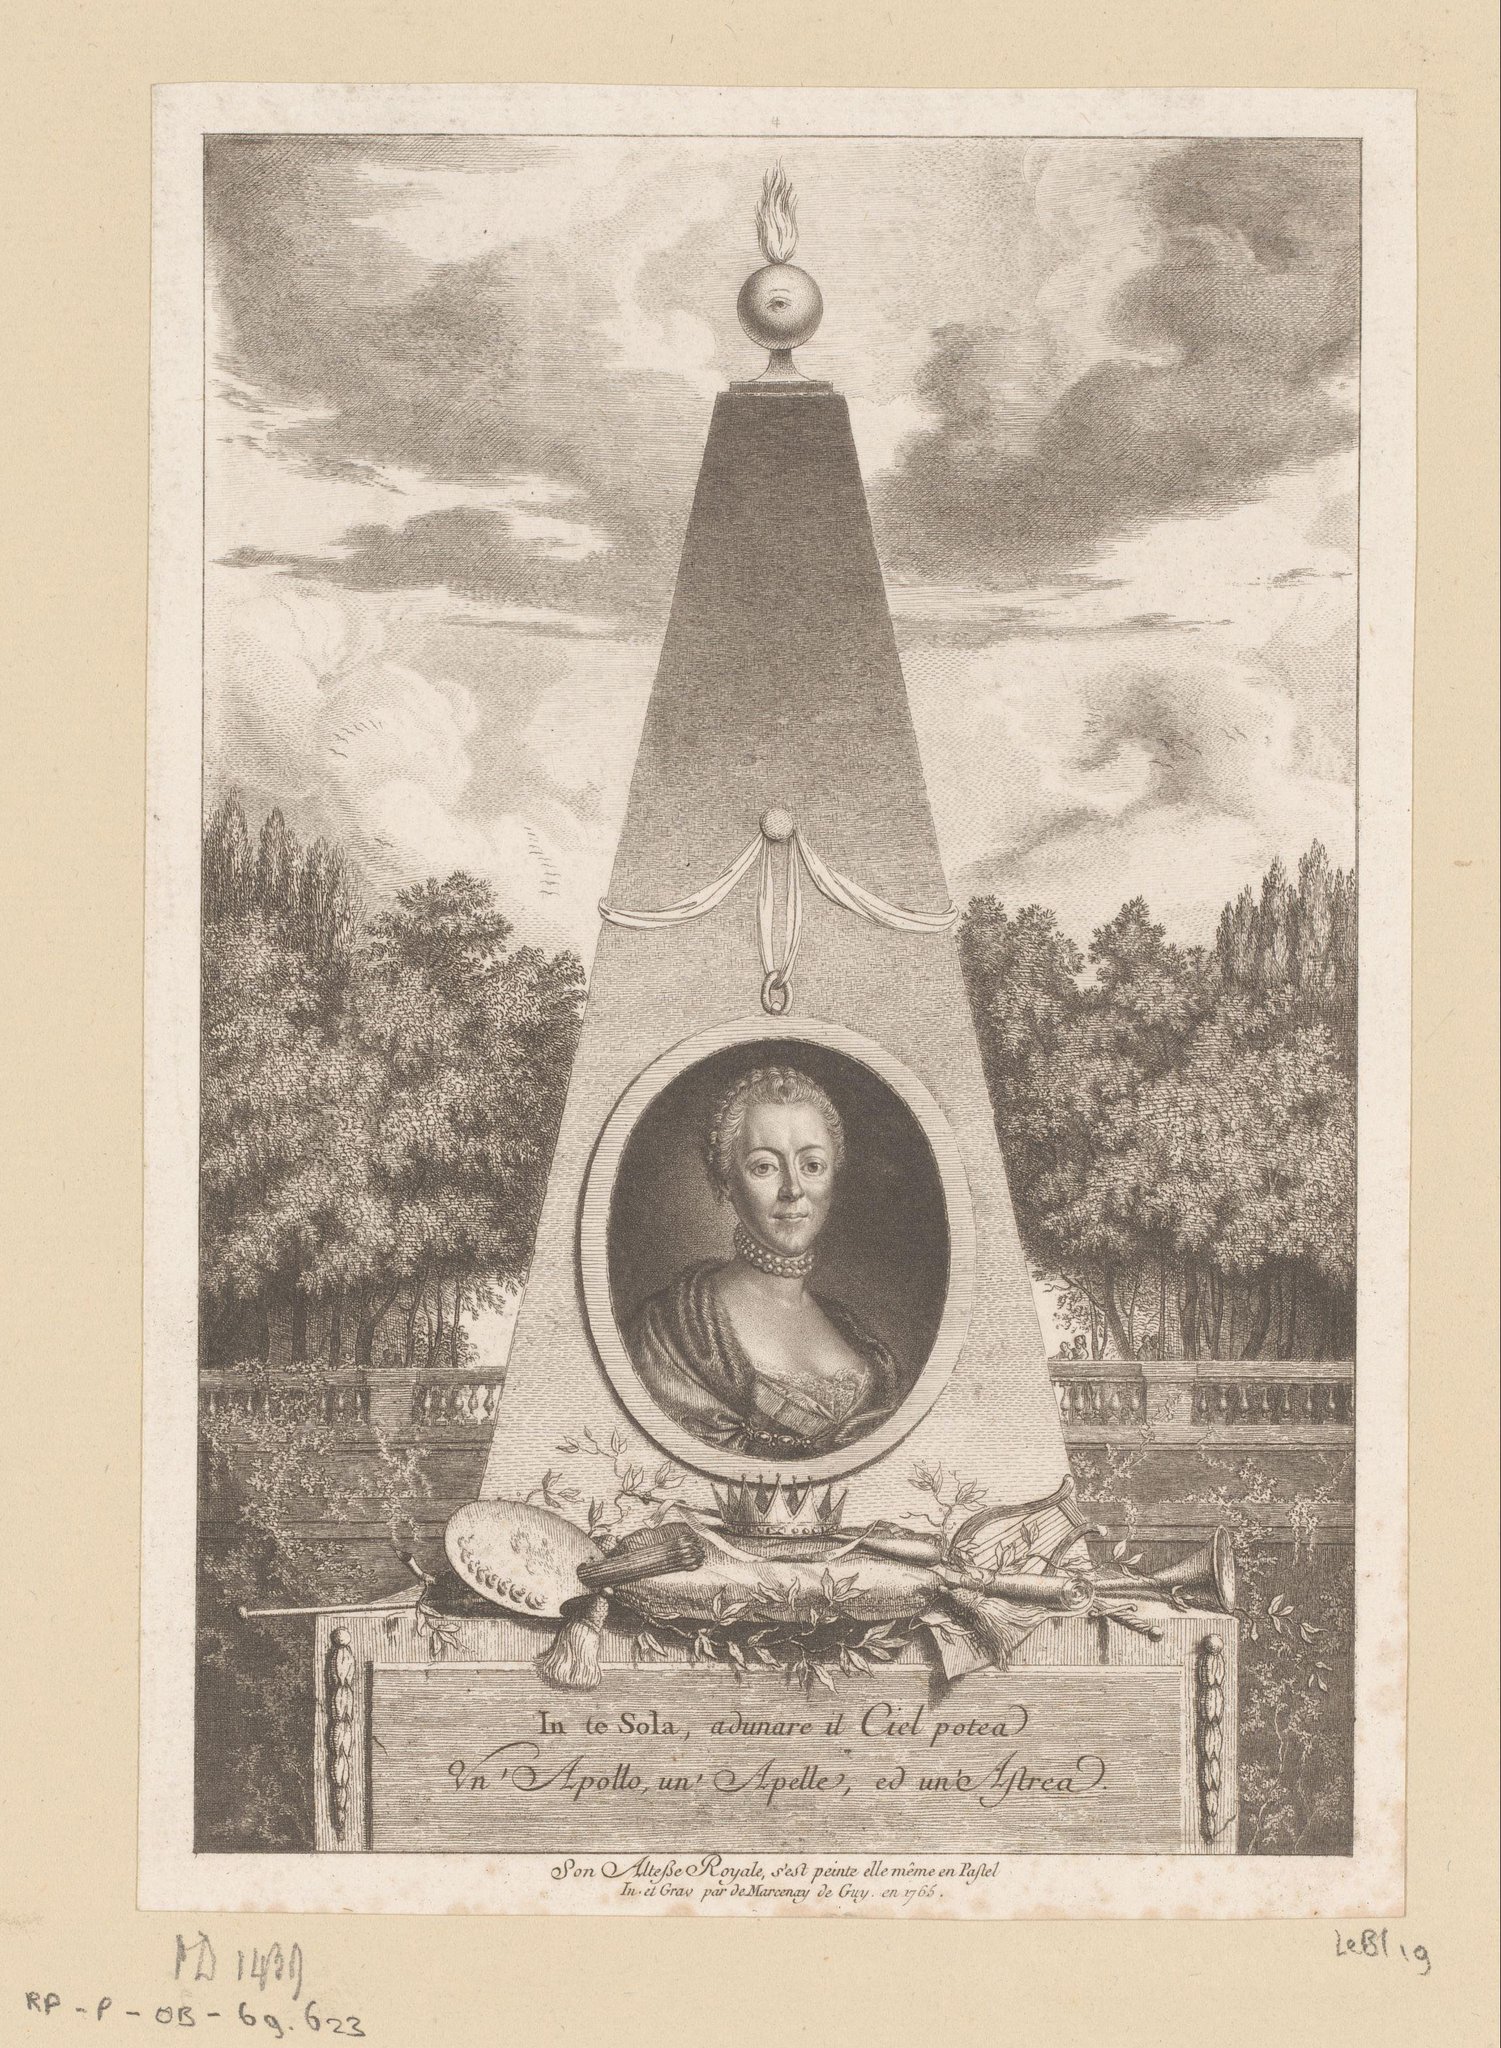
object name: print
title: Portret van Maria Antonia van Beieren in een medaillon op een obelisk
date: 1765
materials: paper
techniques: engraving, etching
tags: maria antonia van beieren, obelisks (garden ornaments), ornament ~ medallion, historical persons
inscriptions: collector's mark: Lugt 2228